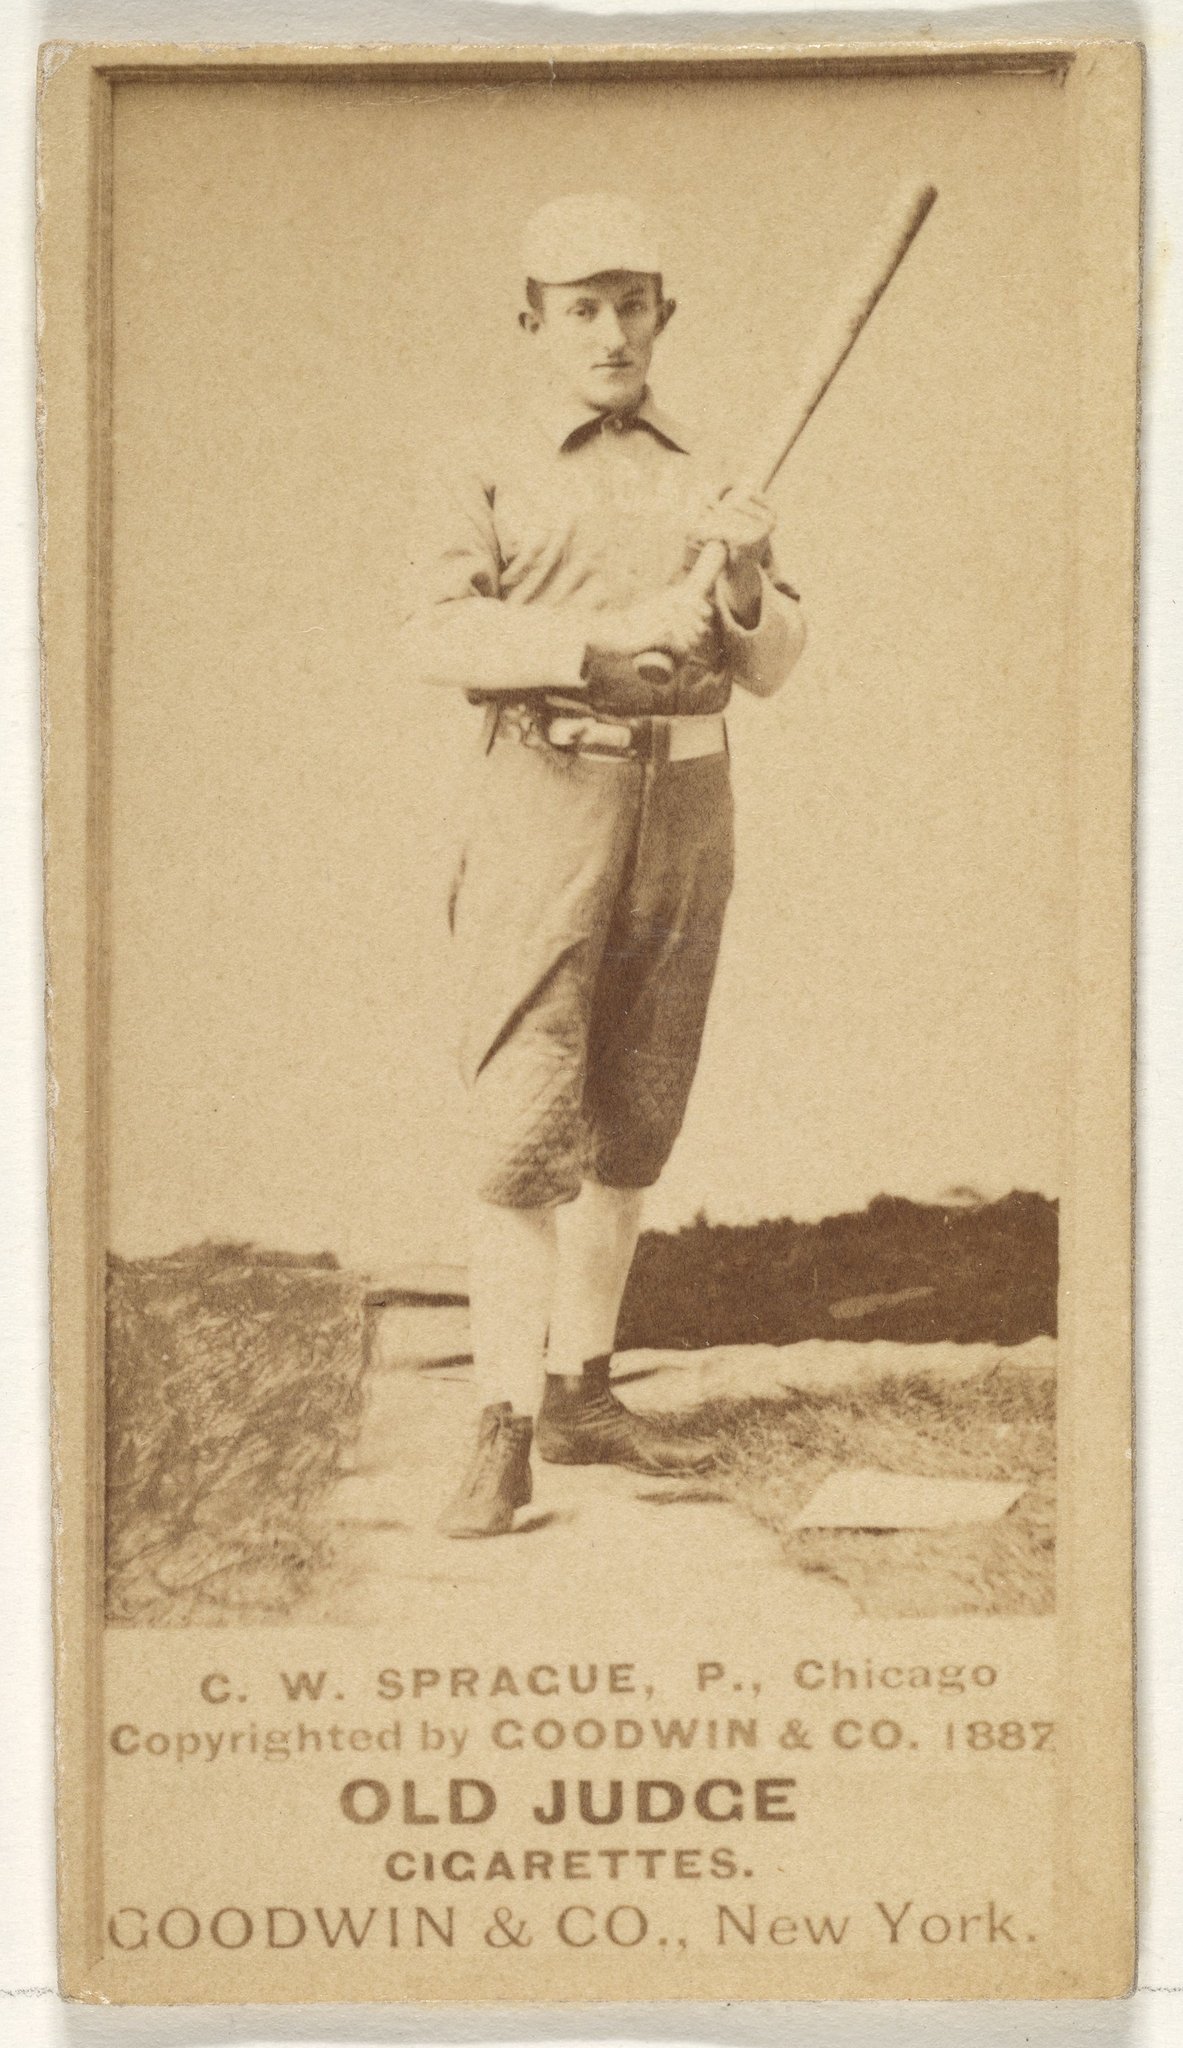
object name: baseball card, photograph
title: Sprague, Pitcher, Chicago, from the Old Judge series (N172) for Old Judge Cigarettes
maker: goodwin & company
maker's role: publisher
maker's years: 1850-1950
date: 1887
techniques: albumen silver print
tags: men,portraits,baseball,athletes